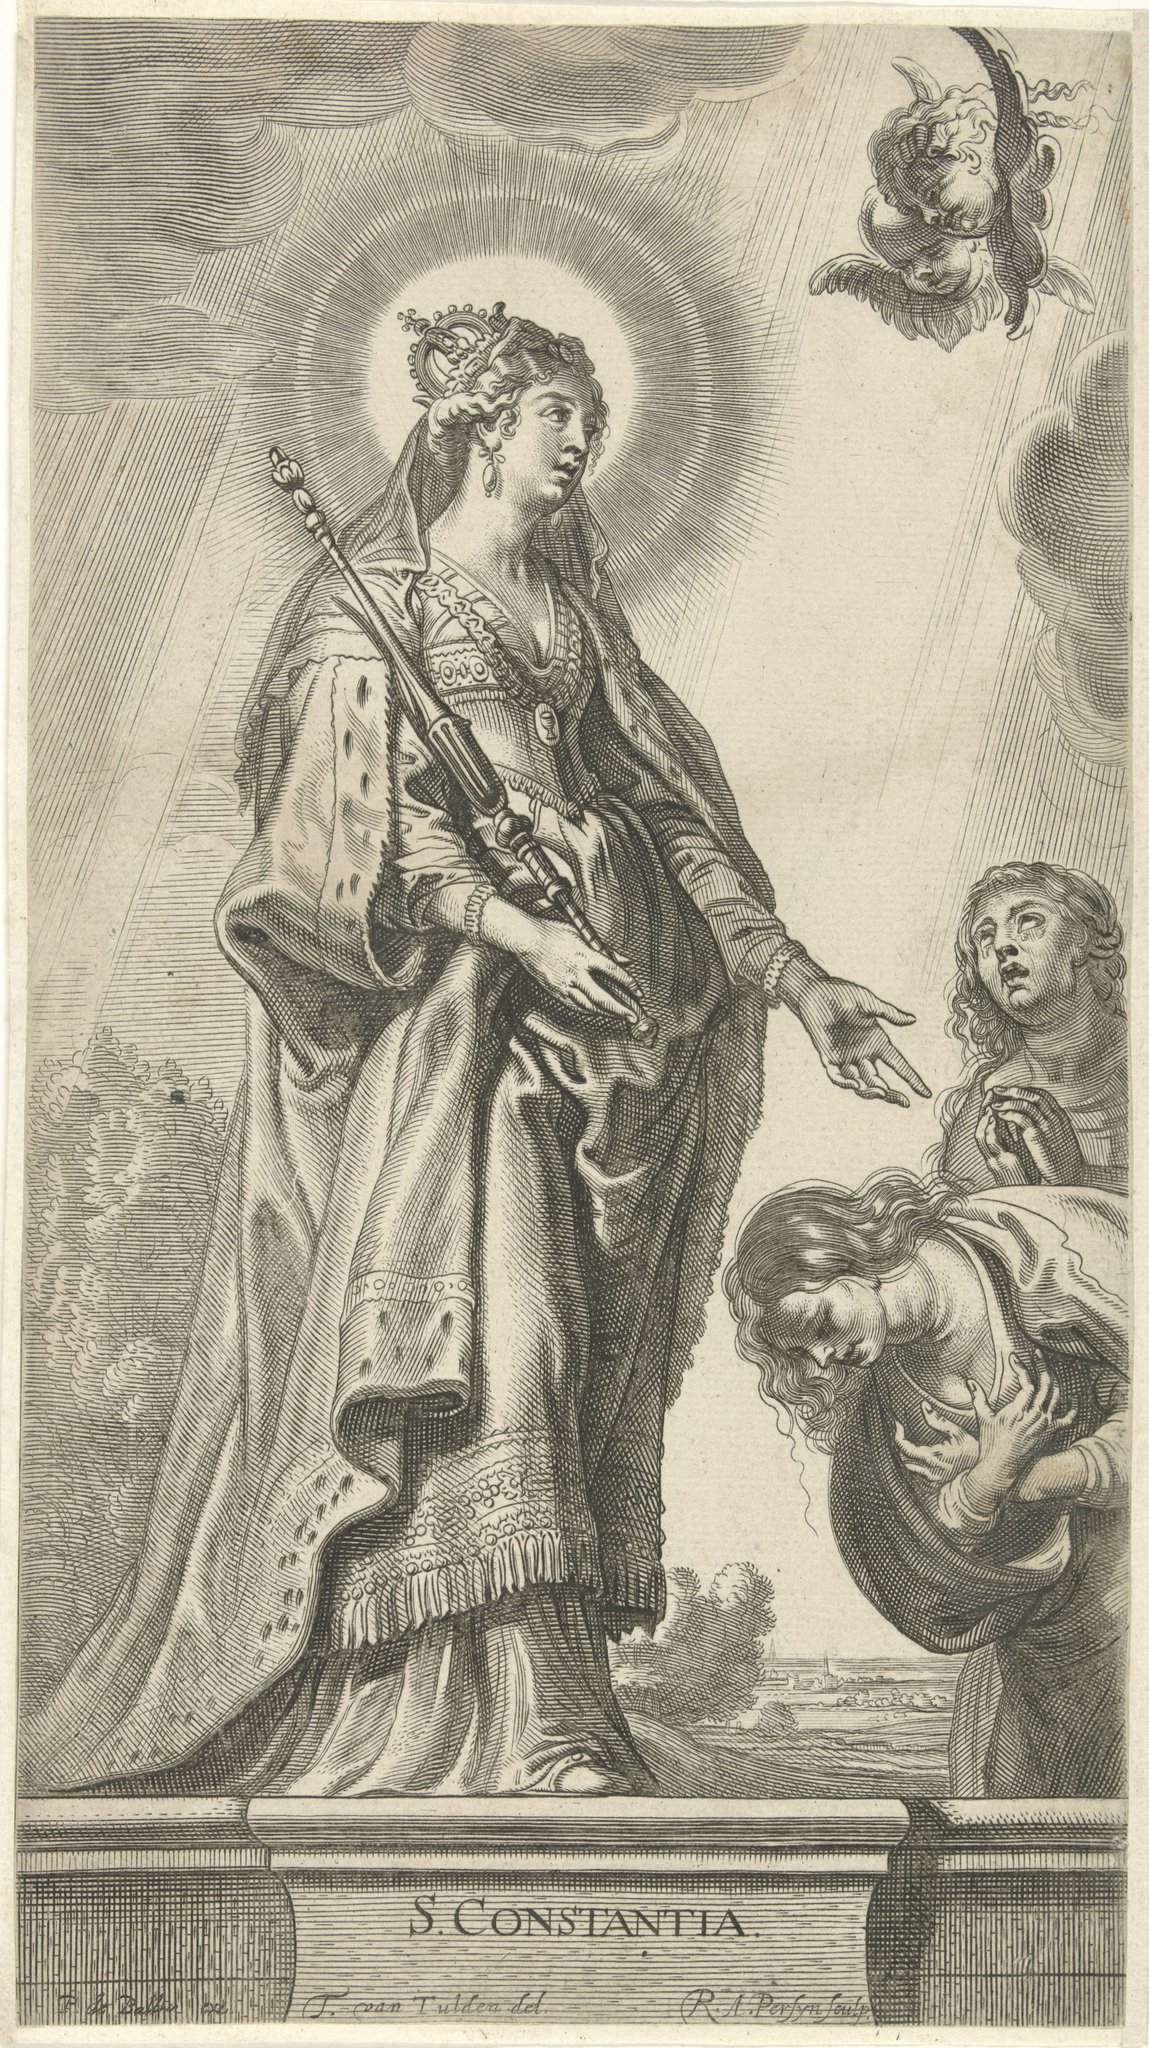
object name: print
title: H. Constantia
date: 1623-1668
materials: paper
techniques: engraving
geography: gouda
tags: female saints (with name)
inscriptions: collector's mark: Lugt 2228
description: Twee vrouwen knielen in aanbidding voor de Heilige Constantia, die is gekroond en een scepter in de handen houdt. Twee cherubijnen kijken toe vanuit de hemel.